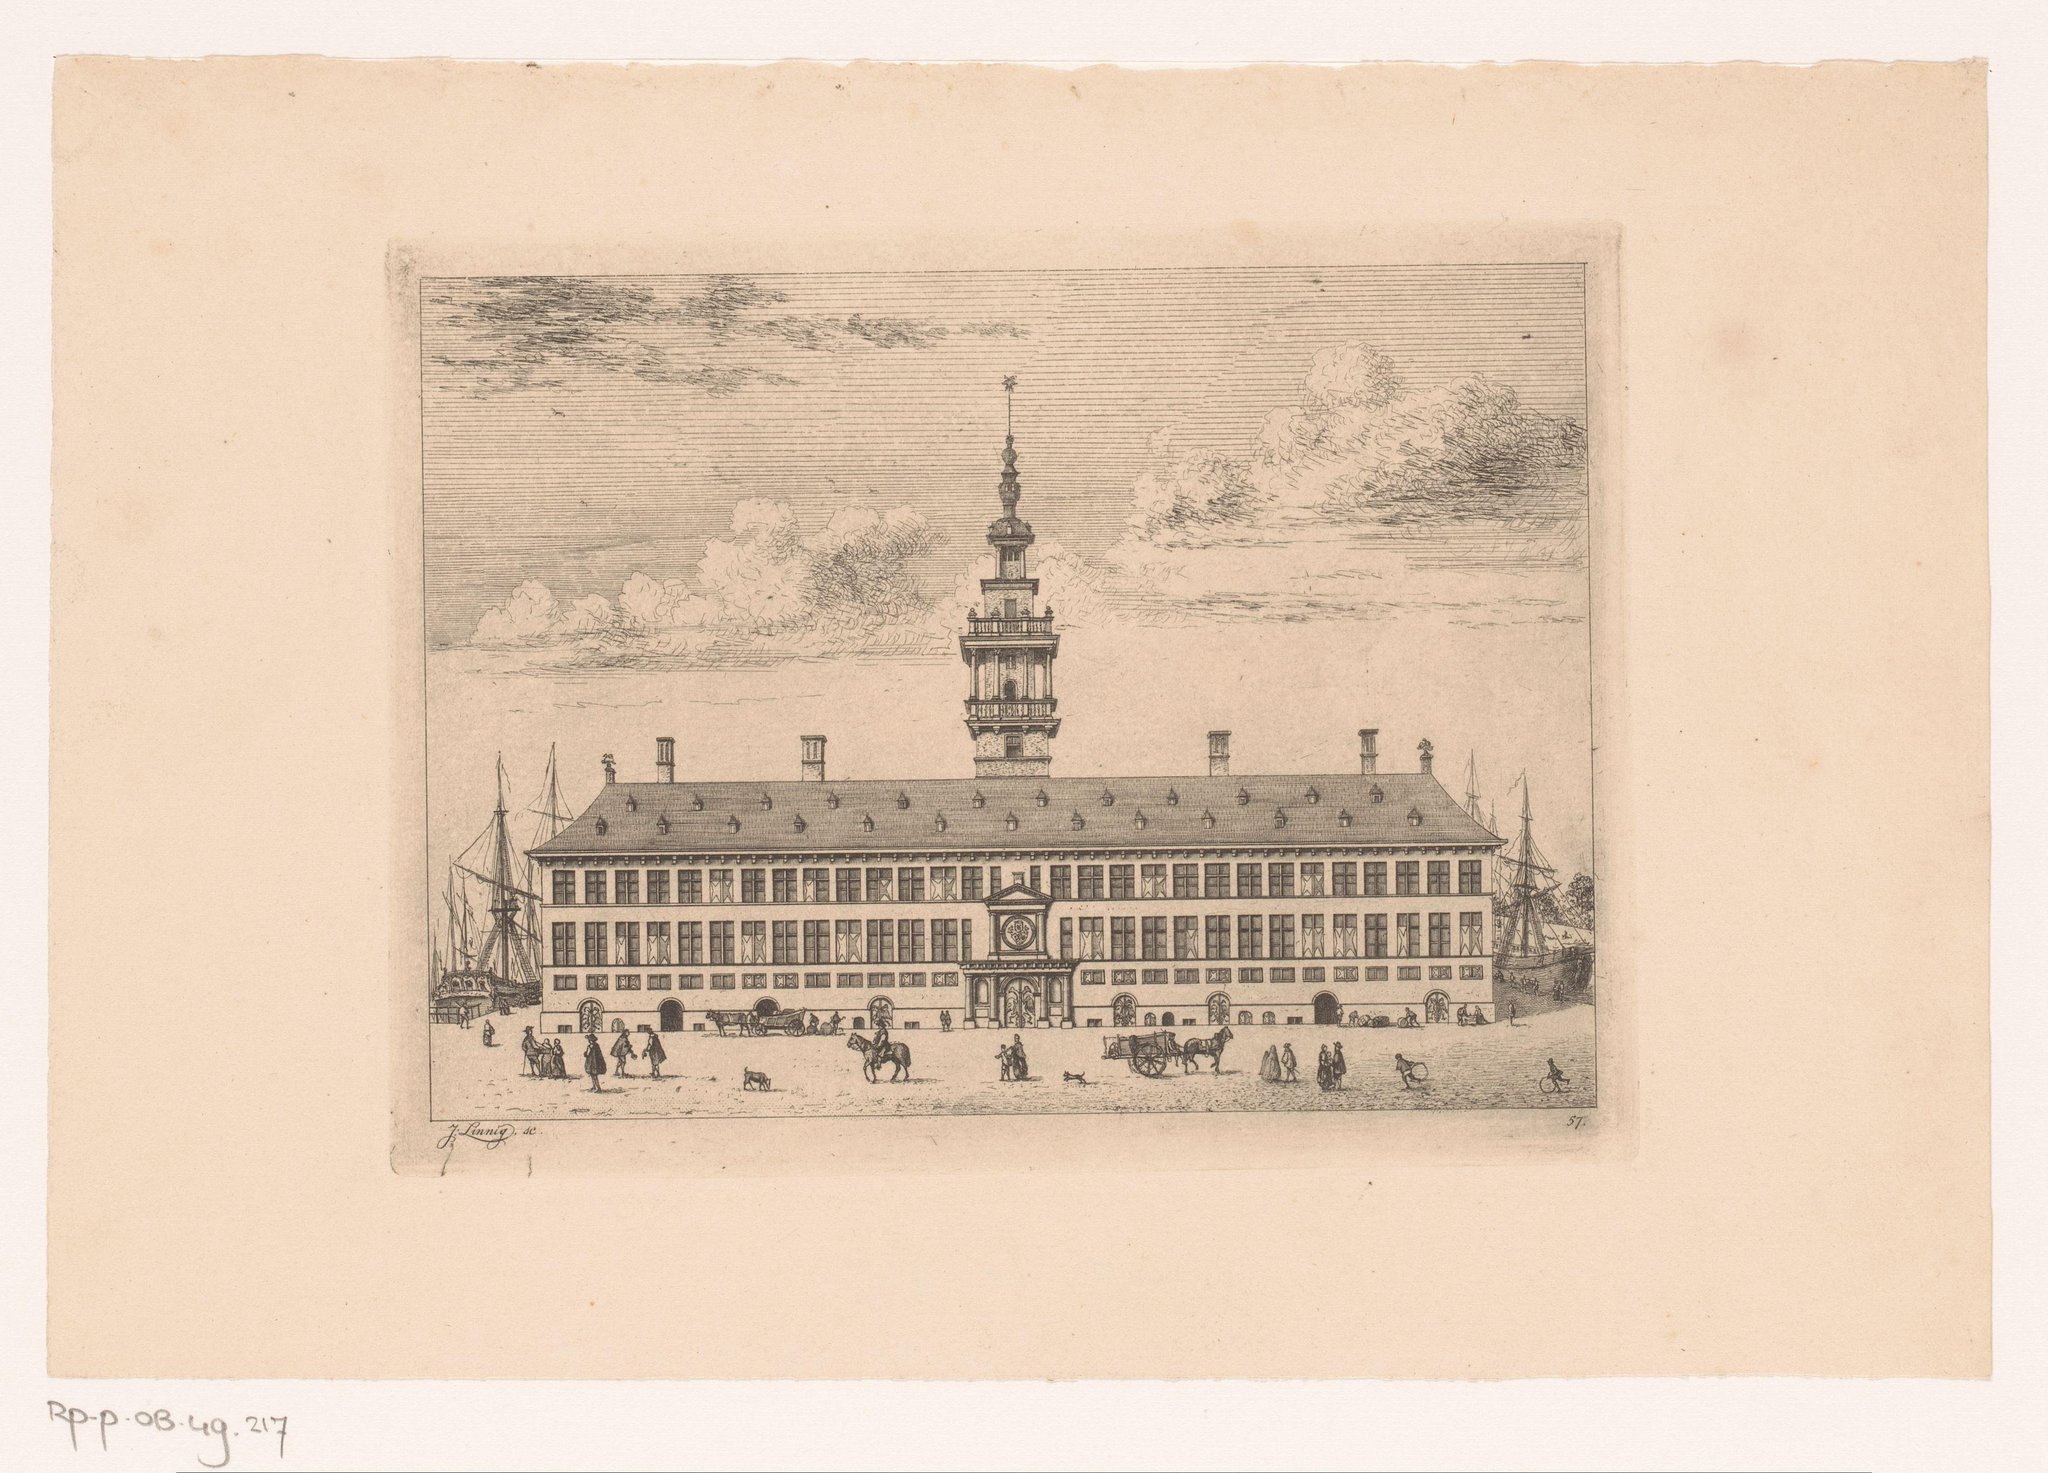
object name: book illustration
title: Gezicht op het Oosters- of Hanzehuis in Antwerpen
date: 1868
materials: paper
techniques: etching, intaglio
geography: antwerp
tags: sailing-ship, sailing-boat, civic architecture; edifices; dwellings, antwerp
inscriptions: collector's mark: Lugt 2228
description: Prent uit: Mertens, F.H. Album historique de la ville d'Anvers [...]. Antwerpen: J.E. Buschmann, 1868.